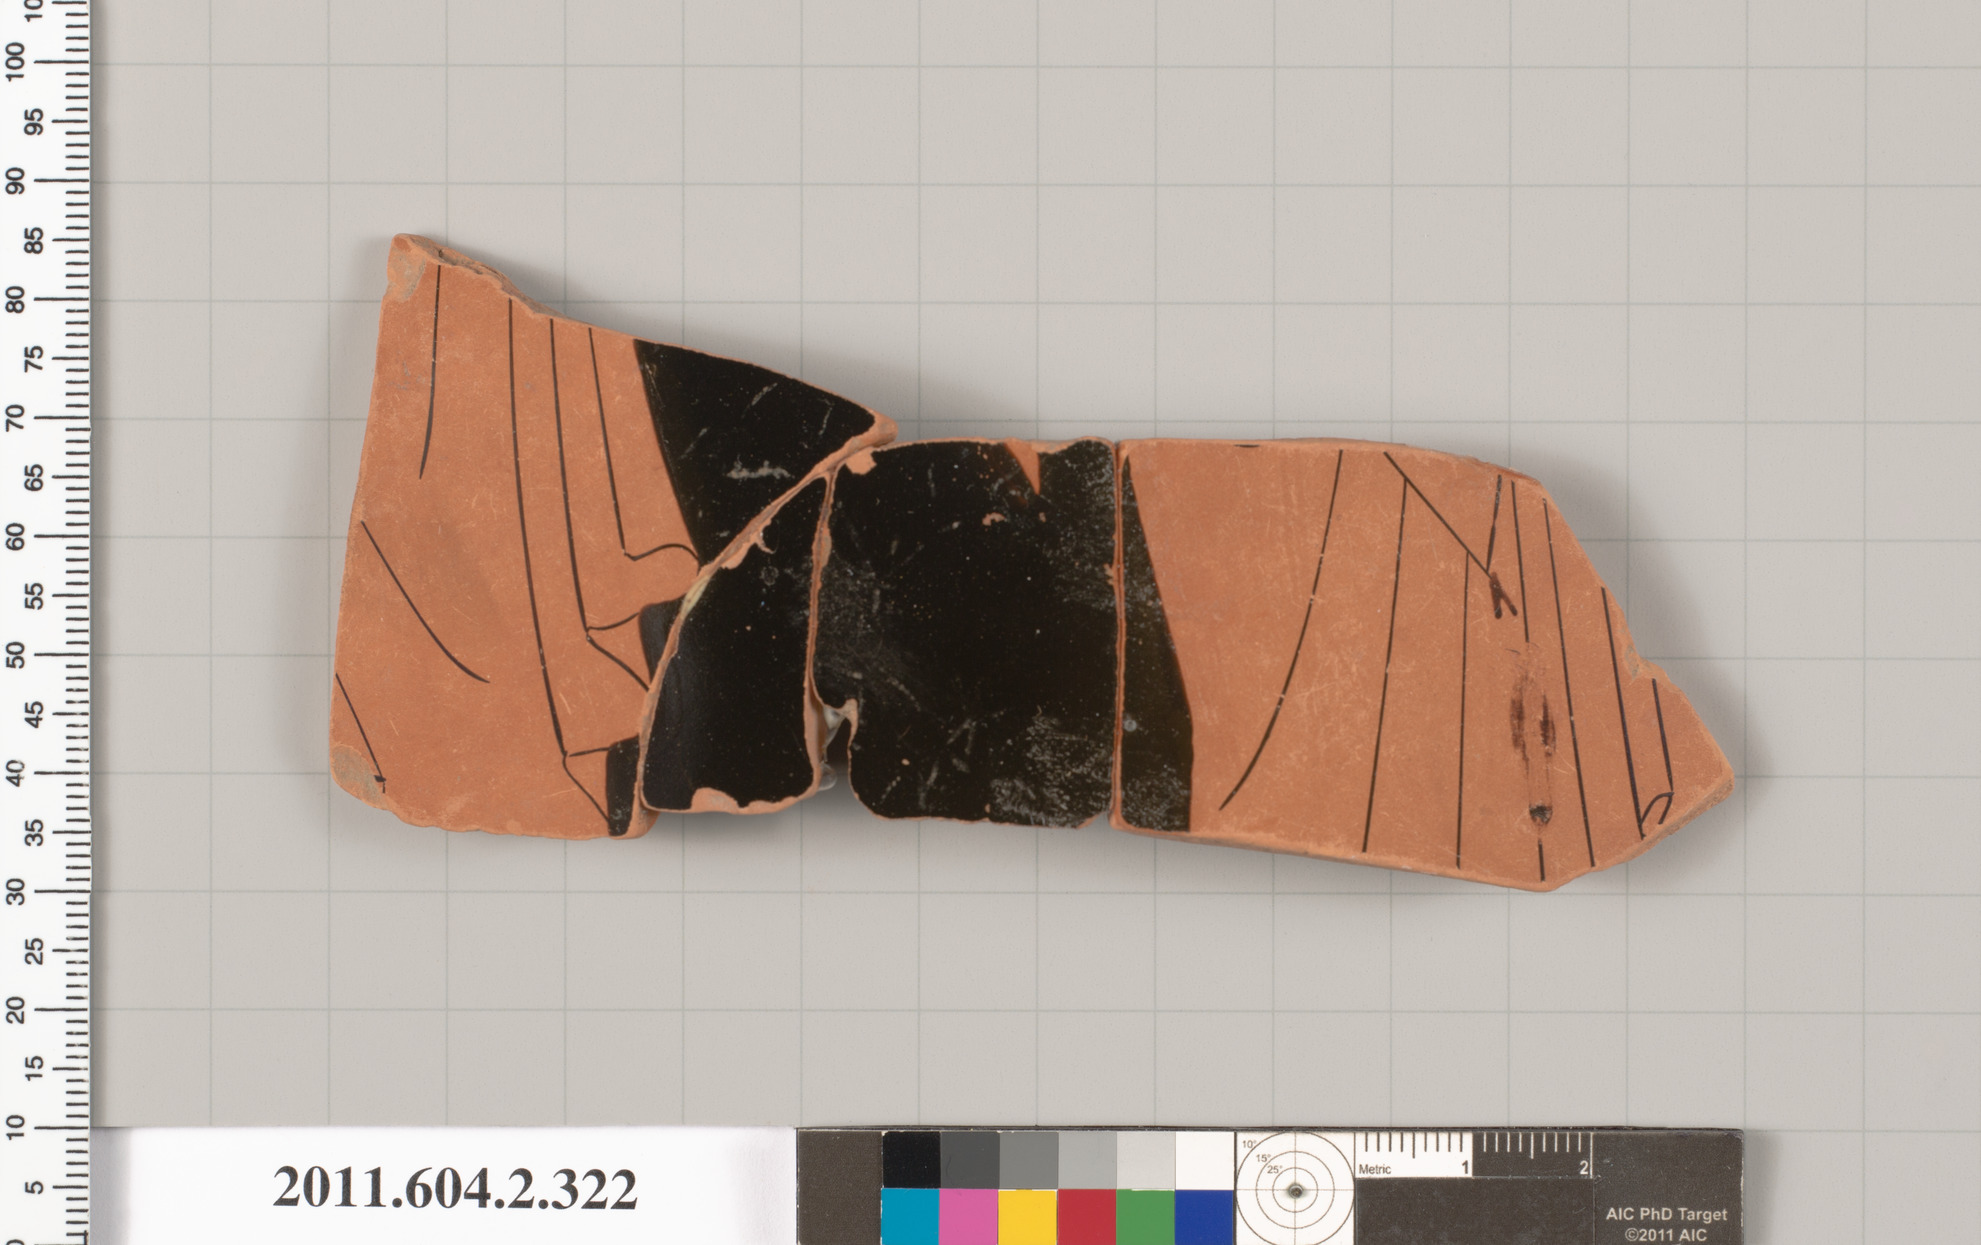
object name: column krater fragment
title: Terracotta fragment of a column-krater (bowl for mixing wine and water)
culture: greek, attic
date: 467-435 BCE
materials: terracotta